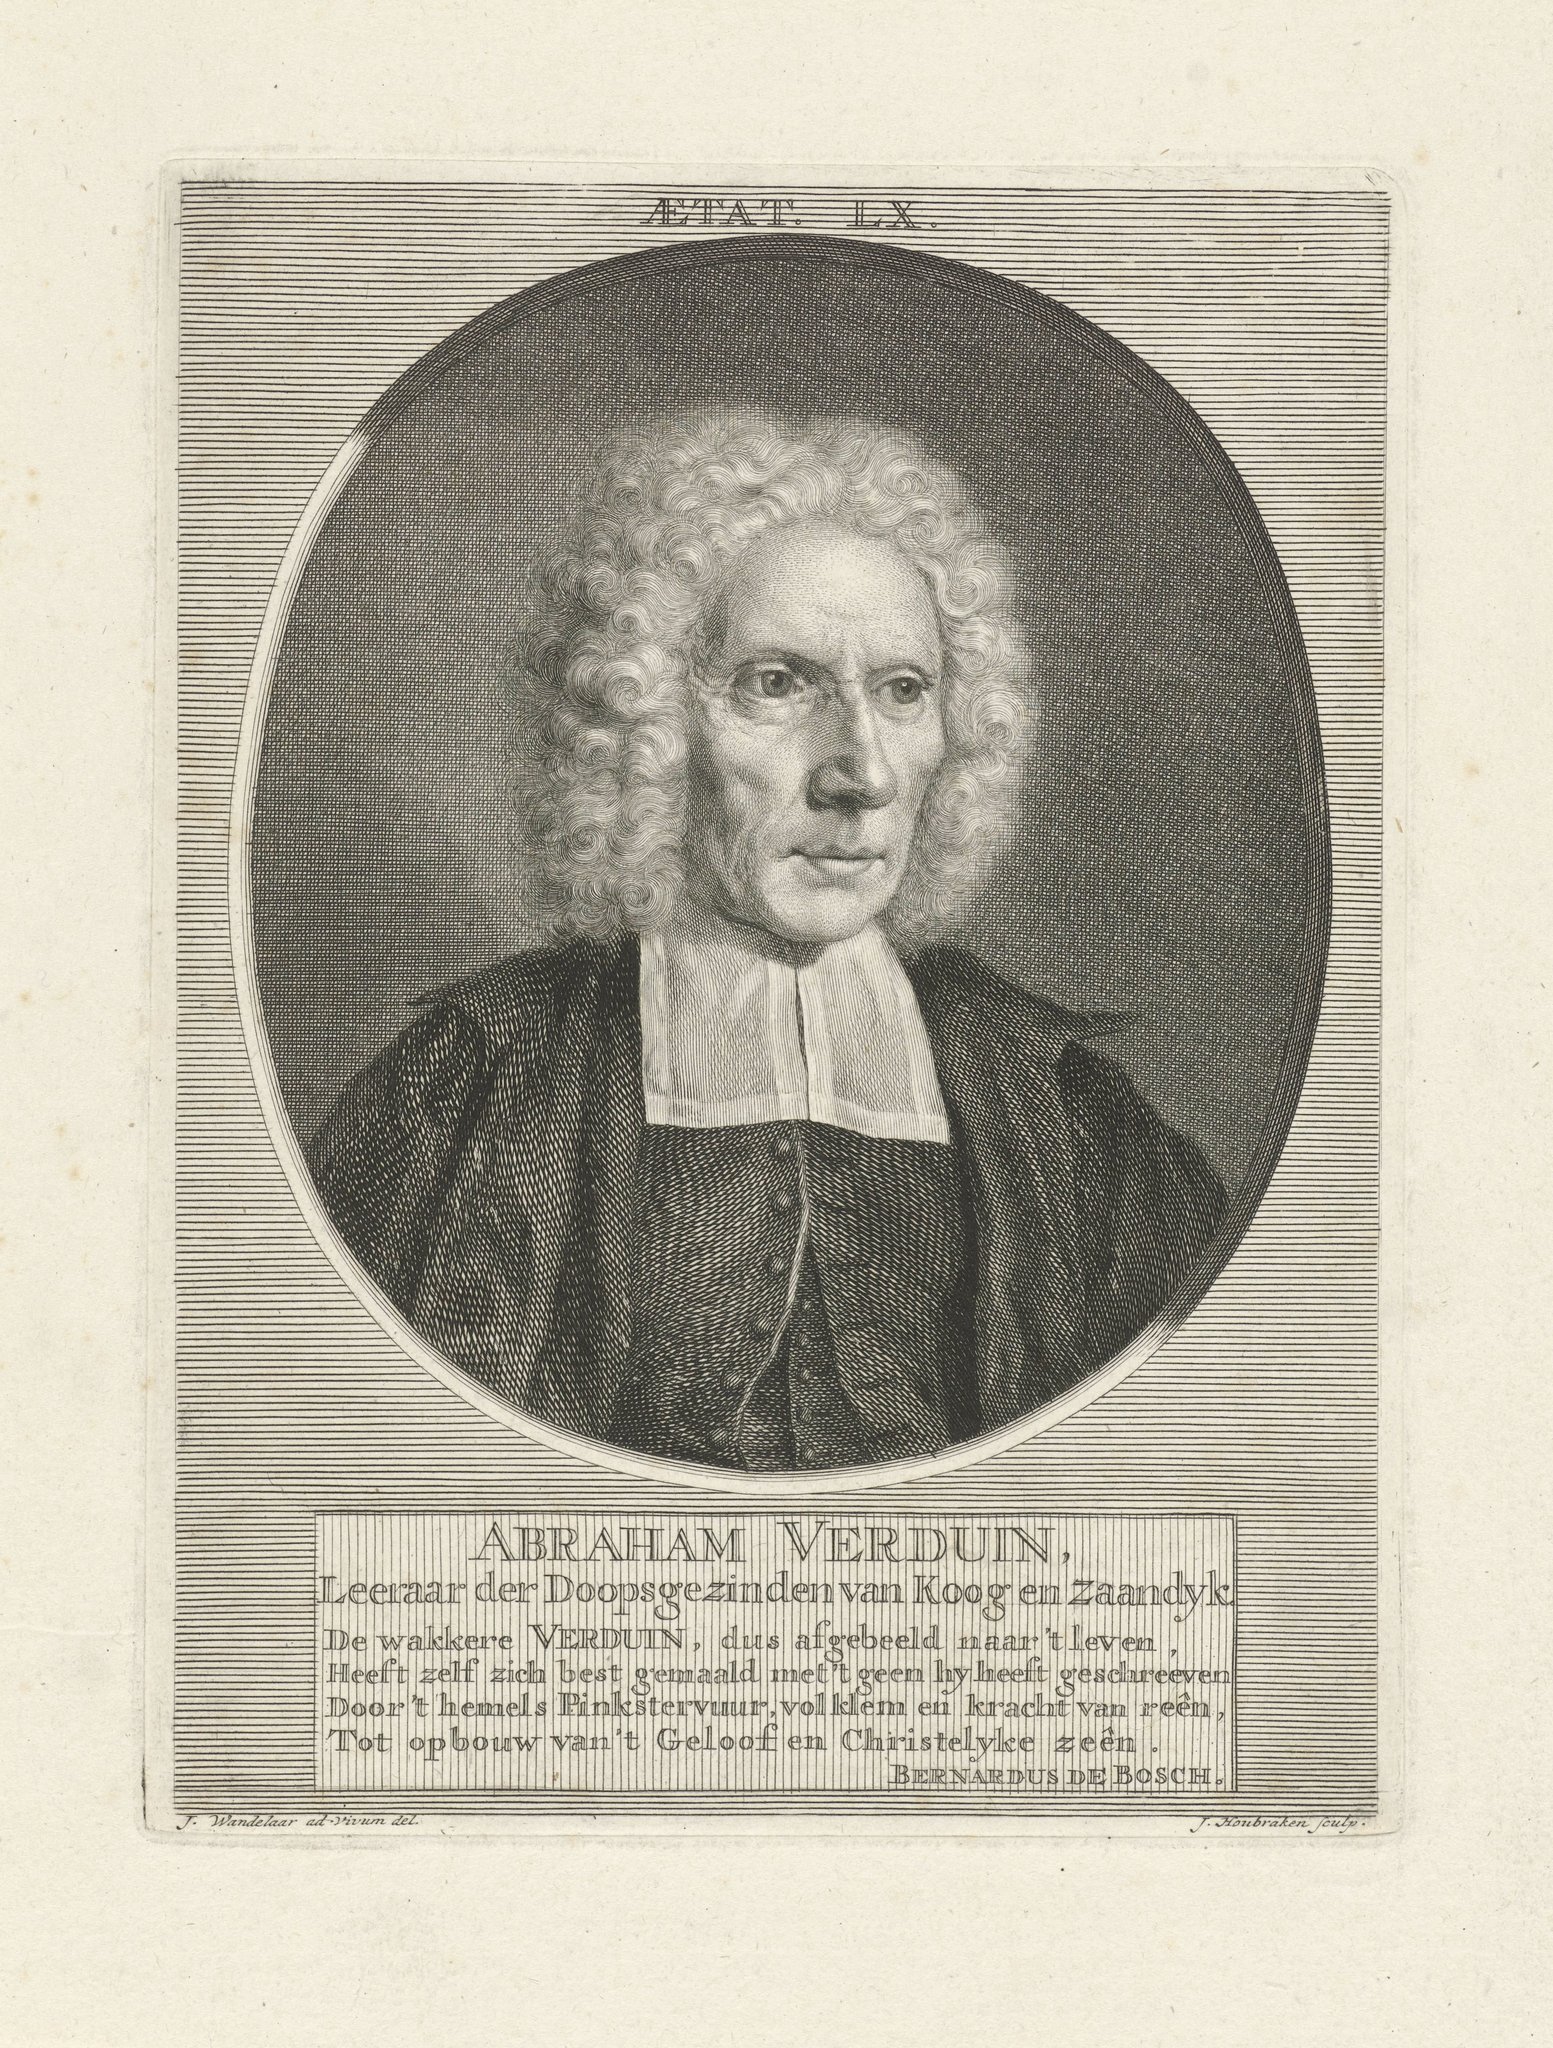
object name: print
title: Abraham Verduin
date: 1747-1780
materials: paper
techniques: engraving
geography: amsterdam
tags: amsterdam, koog aan de zaan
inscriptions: collector's mark: Lugt 240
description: Buste naar rechts van Abraham Verduin op 60-jarige leeftijd in een ovaal. Onder het portret zijn naam en gegevens in twee regels in het Nederlands en daaronder een vierregelig vers in het Nederlands.